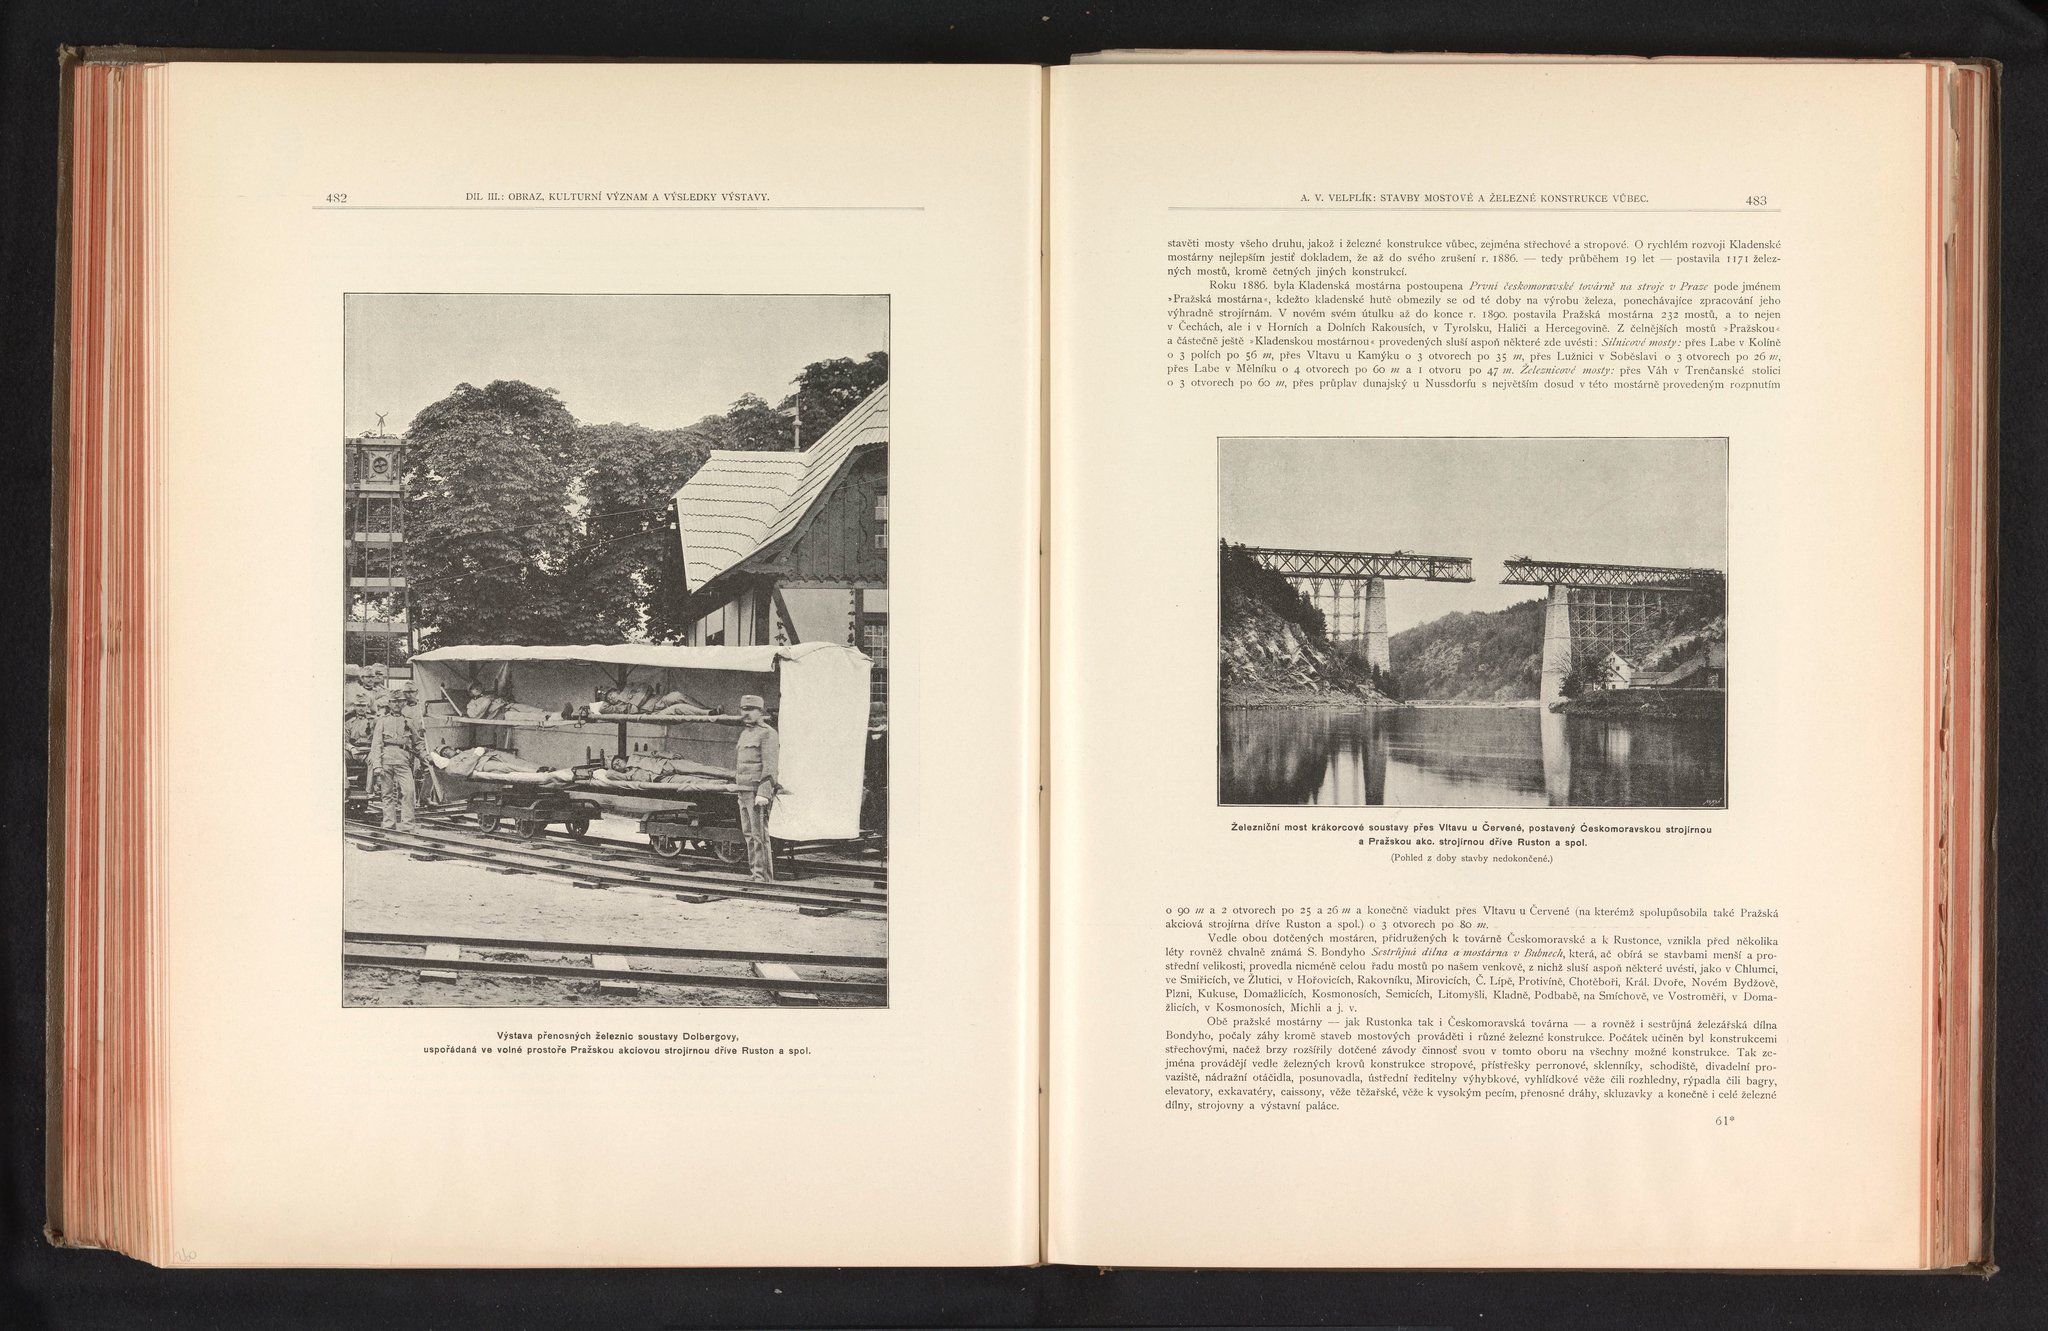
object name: photomechanical print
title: Zeleznicni most krákorcové soustavy pres Vltavu u Cervené, postavený Ceskomoravskou strojirnou a Prazskou akc. strojirnou drive Ruston a spol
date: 1891-1895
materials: paper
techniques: autotype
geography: prague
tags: river, railway, tramway; rack railway, bridge